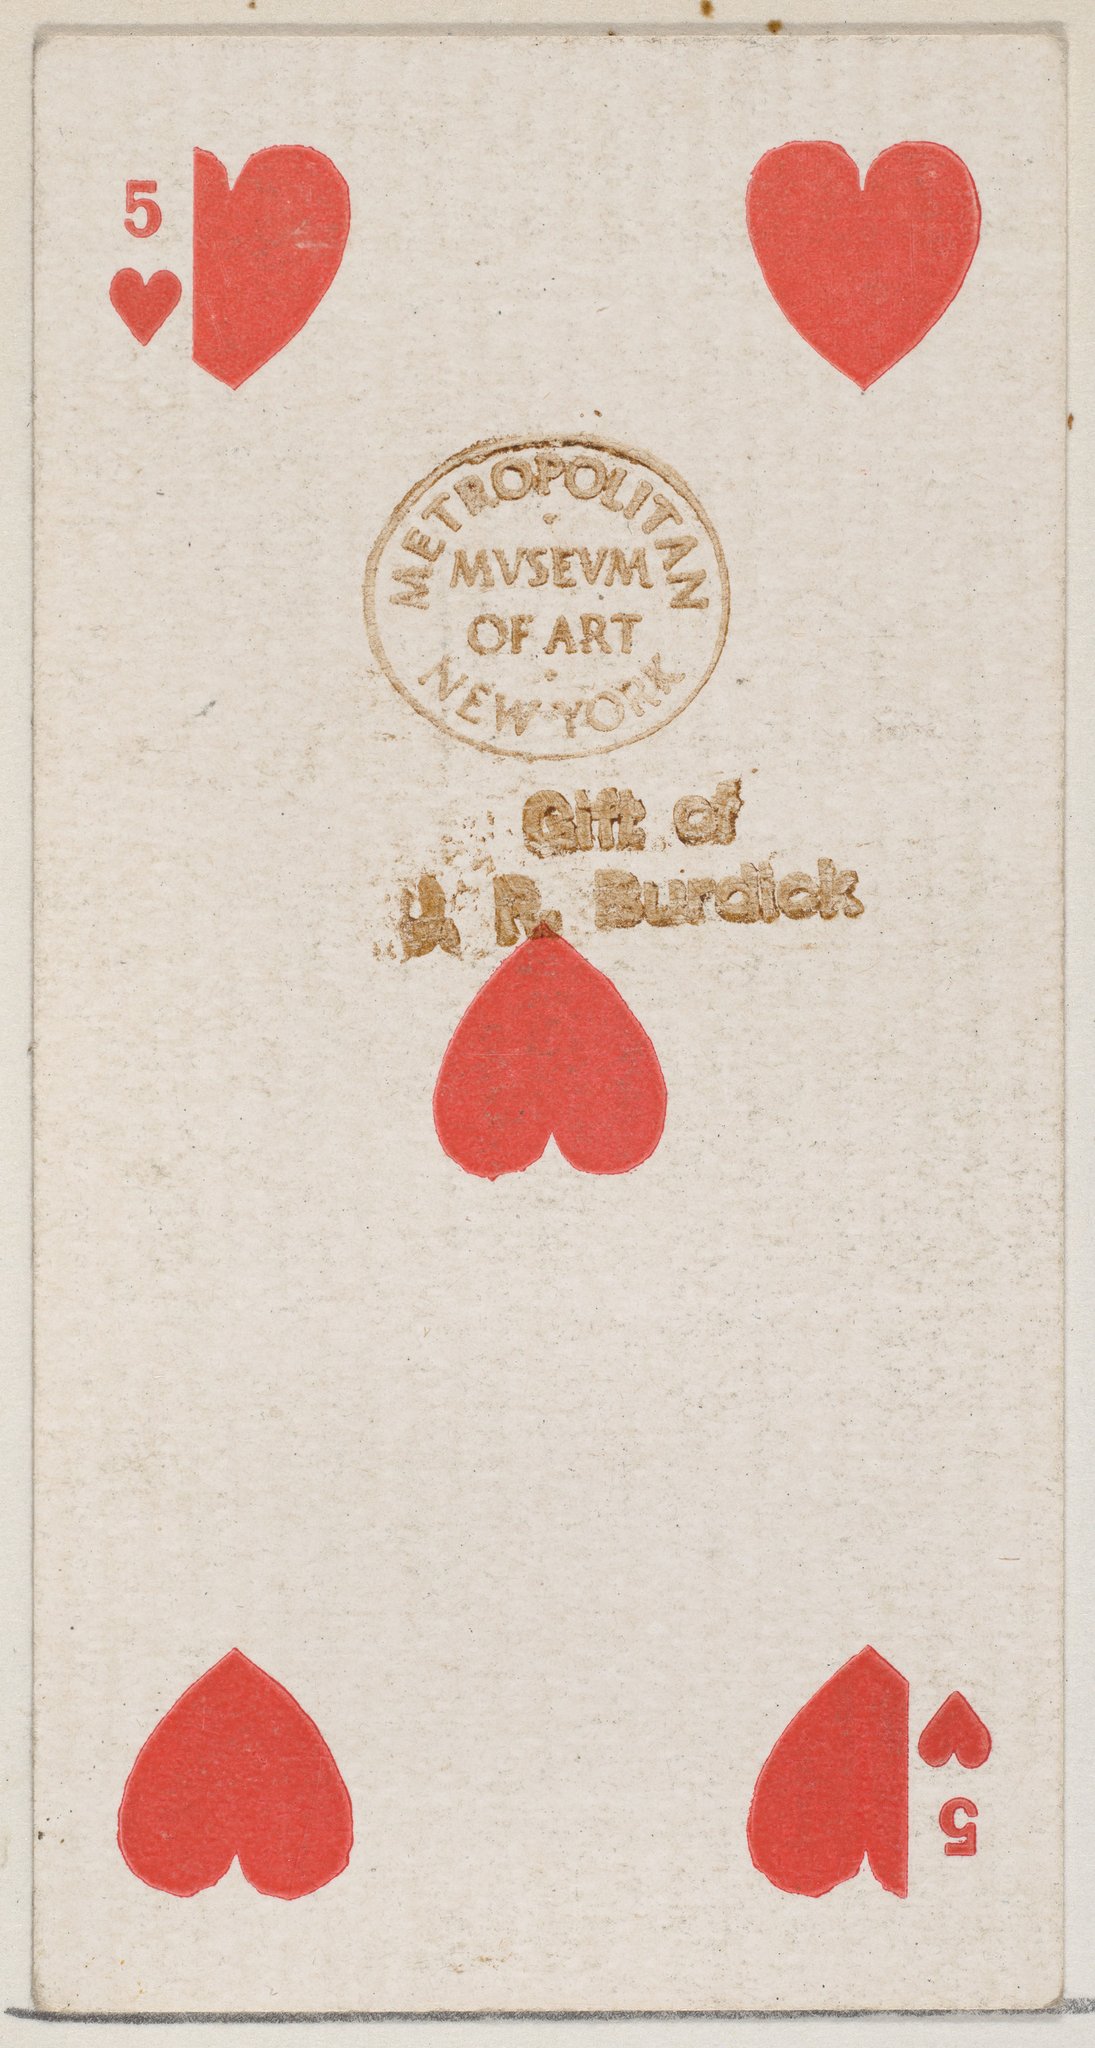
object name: print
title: Five Hearts (red), from the Playing Cards series (N84) for Duke brand cigarettes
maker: w. duke, sons & co.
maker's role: publisher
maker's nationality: american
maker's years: 1870-1920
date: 1888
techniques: color lithograph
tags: playing cards